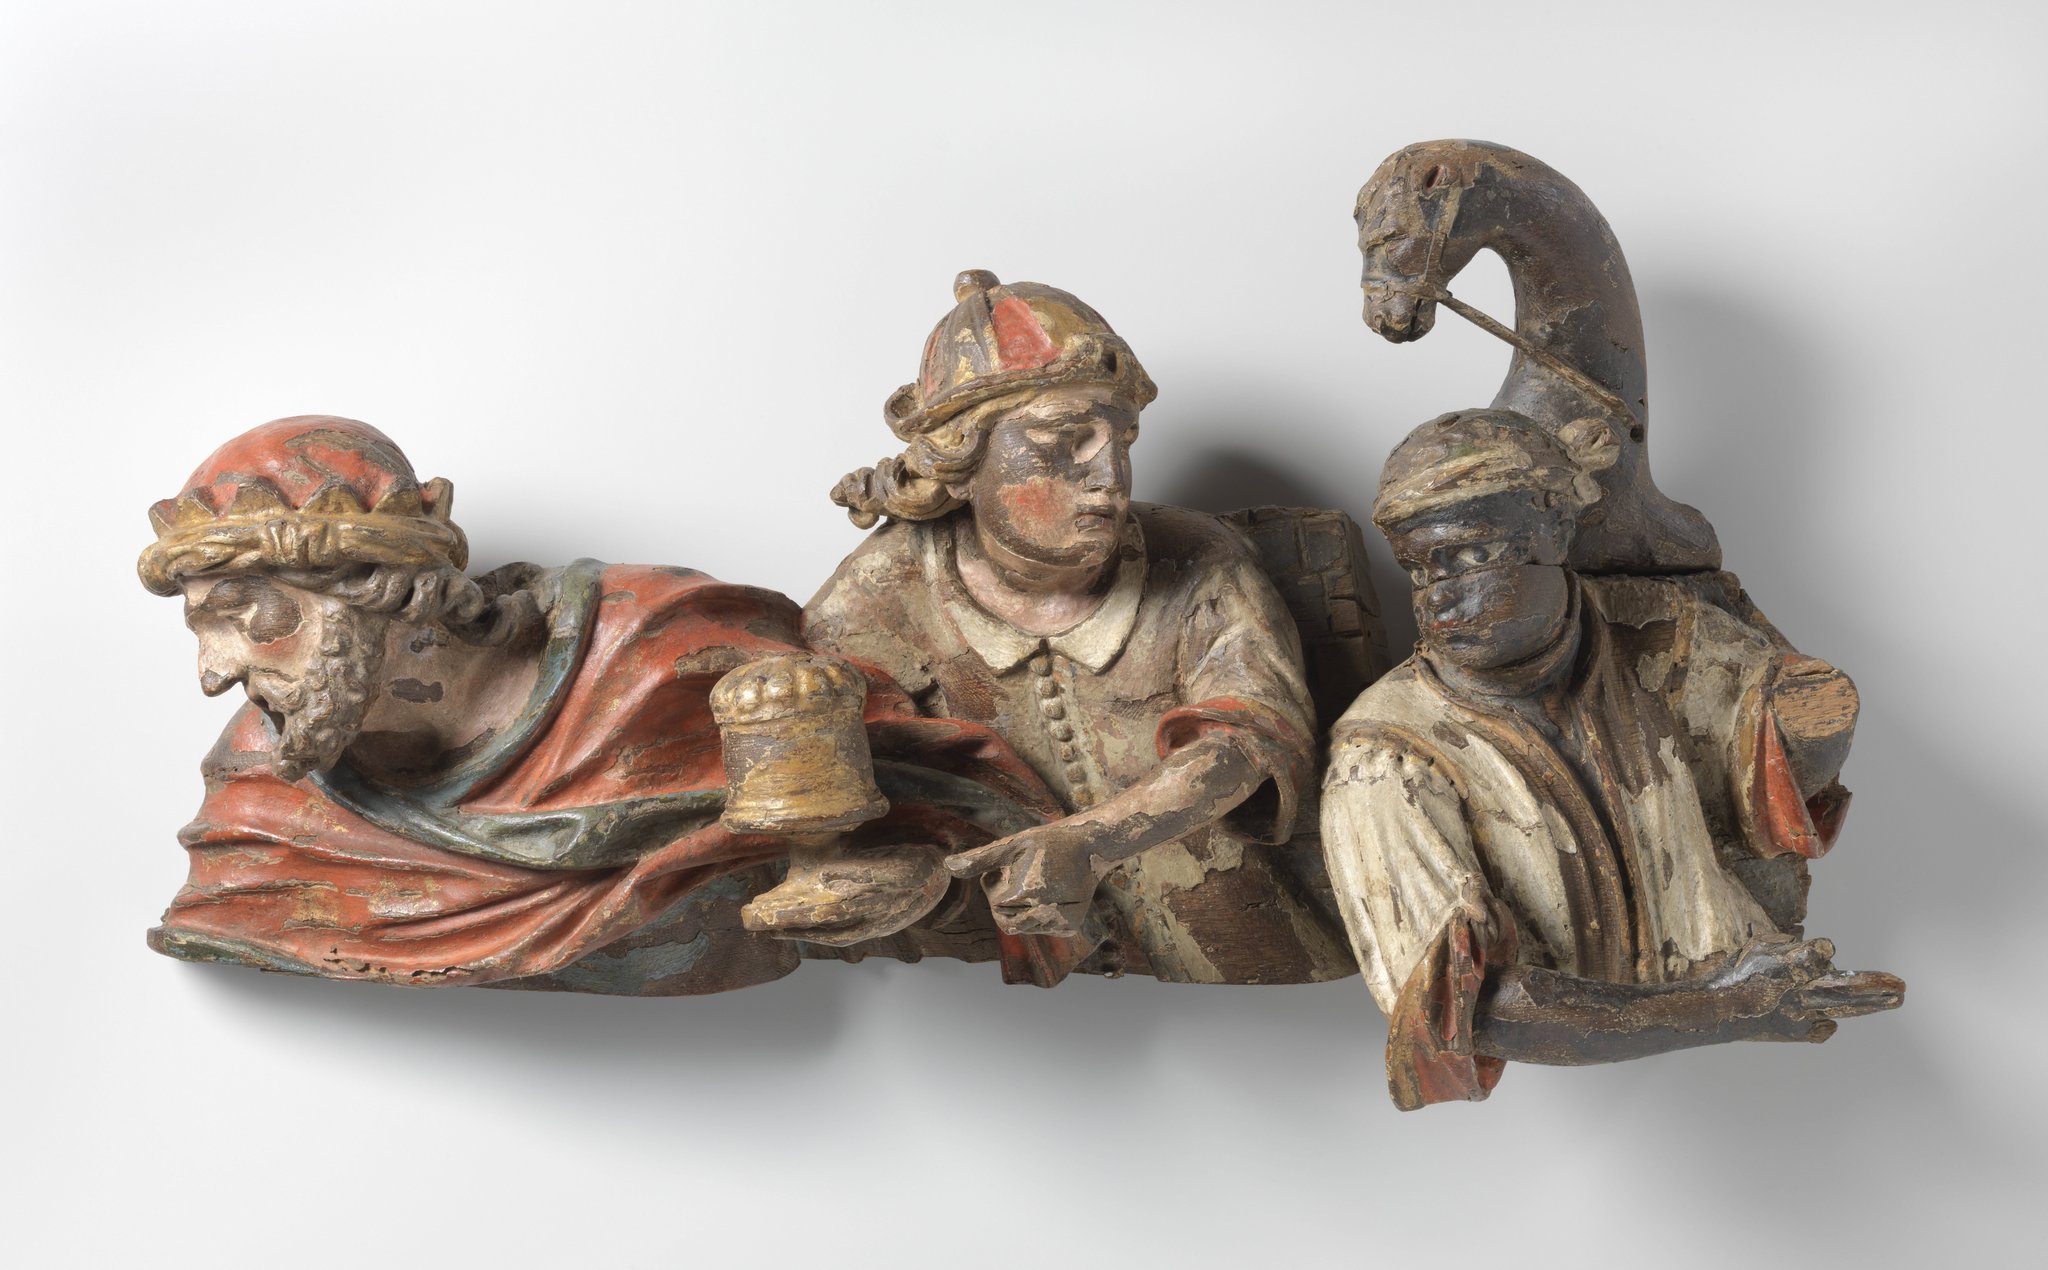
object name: sculpture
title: The Three Magi, from an Adoration of the Magi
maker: Anonymous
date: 1550-1560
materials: wood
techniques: gilding, polychromy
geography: utrecht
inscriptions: inscription, on the back, in a modern hand, in white paint: ‘nºINV. 7331’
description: The Three Magi. Oak with original polychromy. Utrecht, c. 1550.